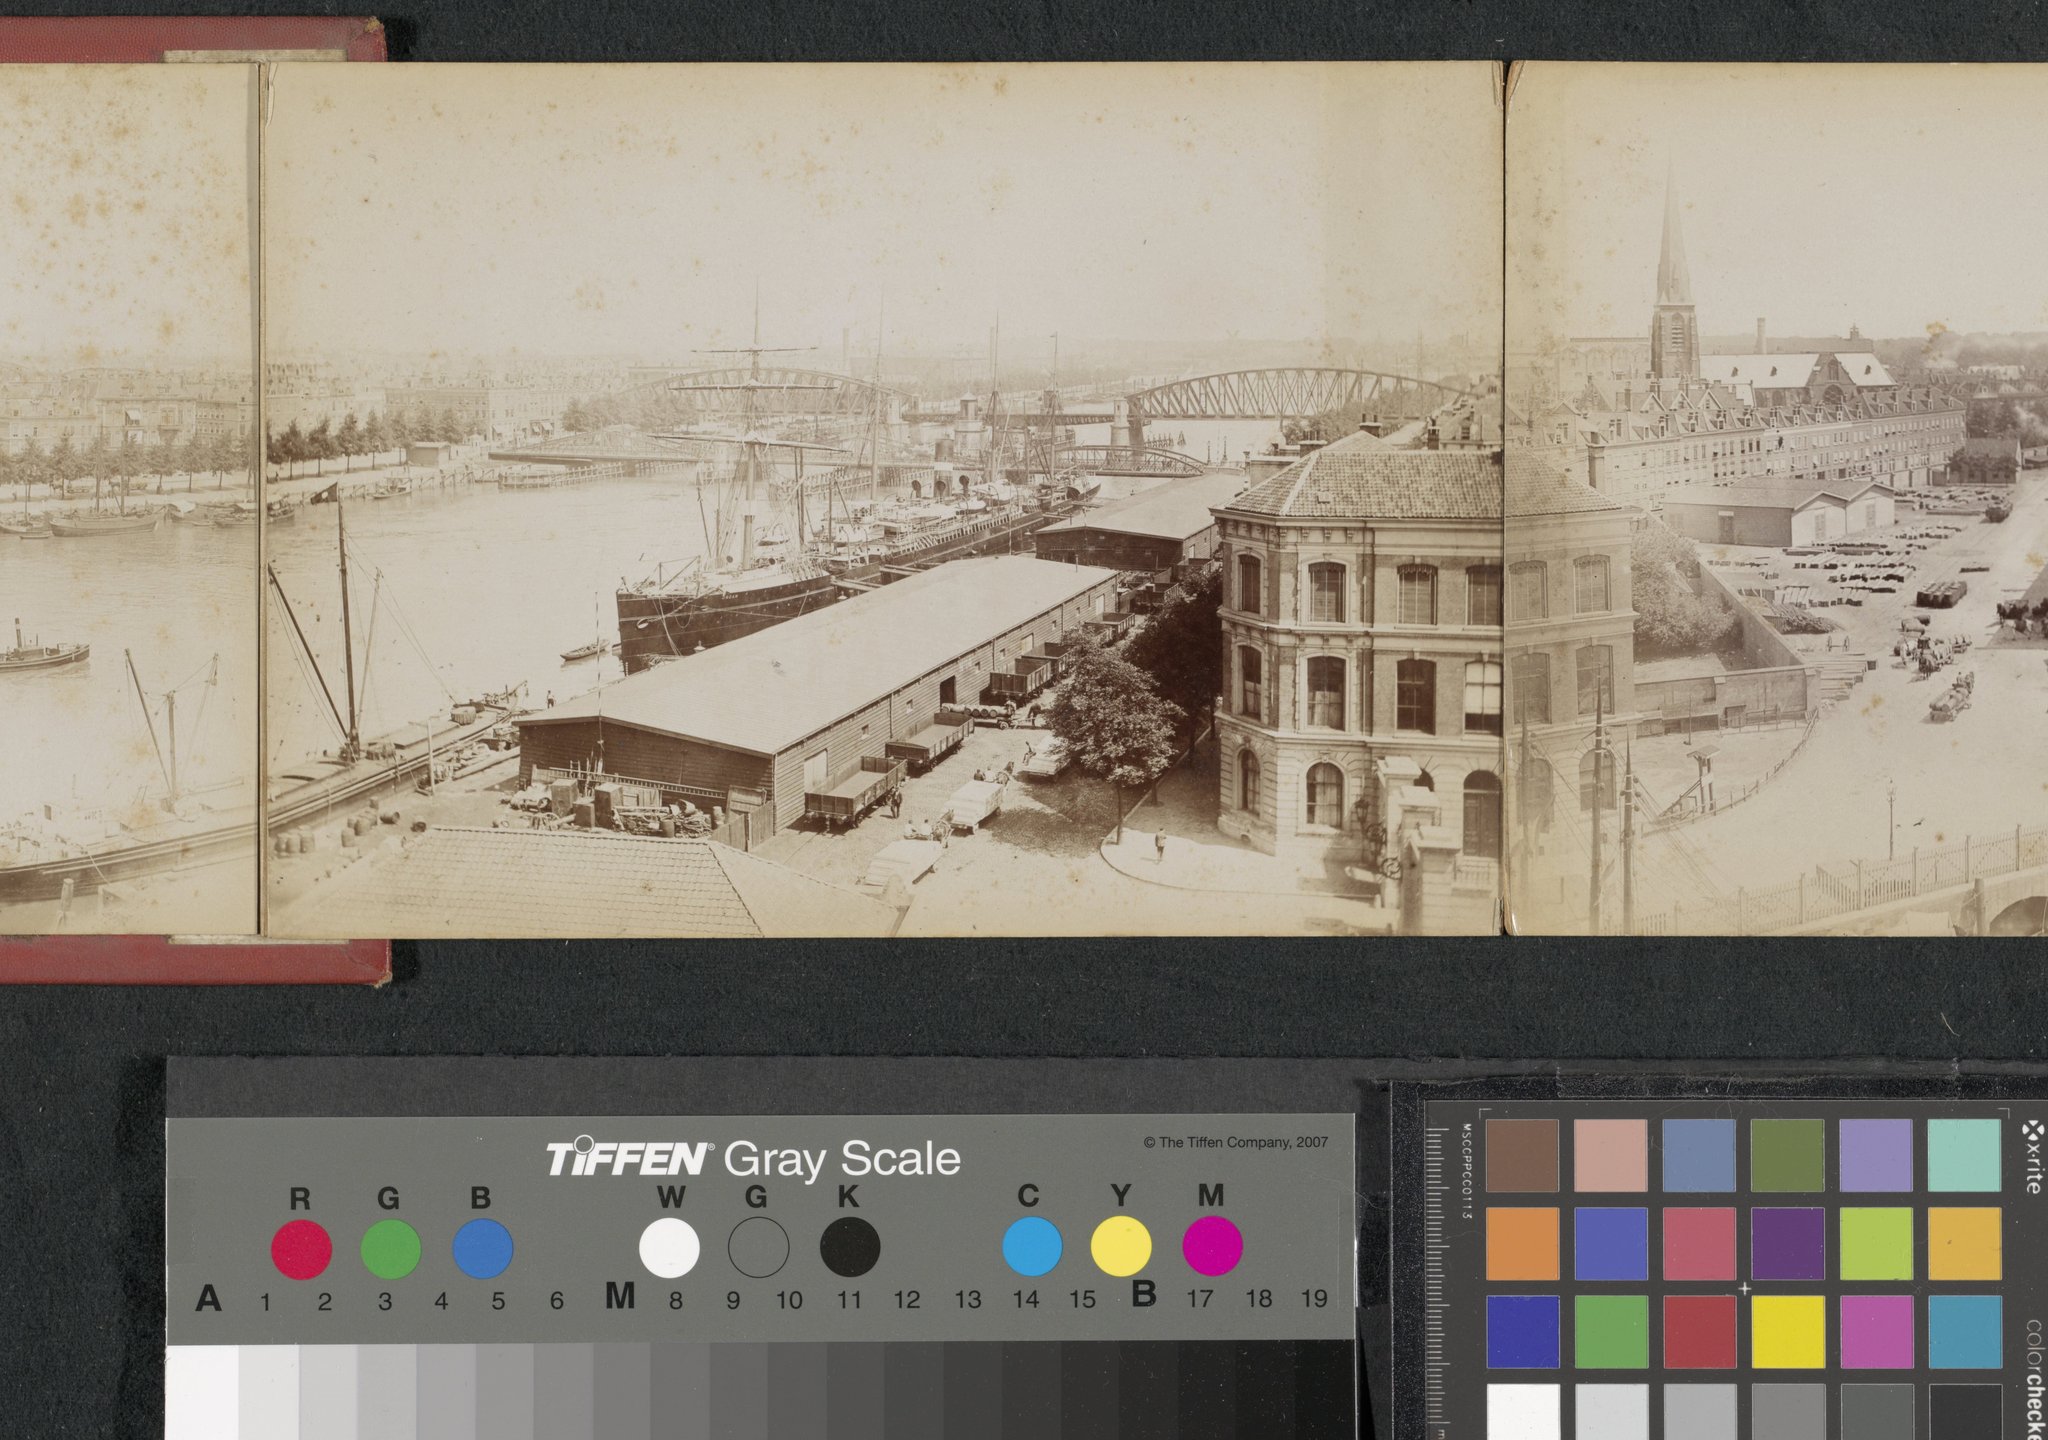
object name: photograph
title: Gezicht op de Koningshaven, de Koningsbrug en de Koninginnebrug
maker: f. von pöppinghausen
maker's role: fotograaf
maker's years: 1851-1905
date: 1878-1900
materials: cardboard, paper, photographic support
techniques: albumen print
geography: rotterdam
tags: harbour, warehouse (~ harbour), river, river bank, pier, quay, wharf, bridge in city across river, canal, etc., prospect of city, town panorama, silhouette of city, steamship, motorship, rotterdam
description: Onderdeel van Panorama van de Rotterdamse haventerreinen op de Kop van Zuid, foto 2 van 7.